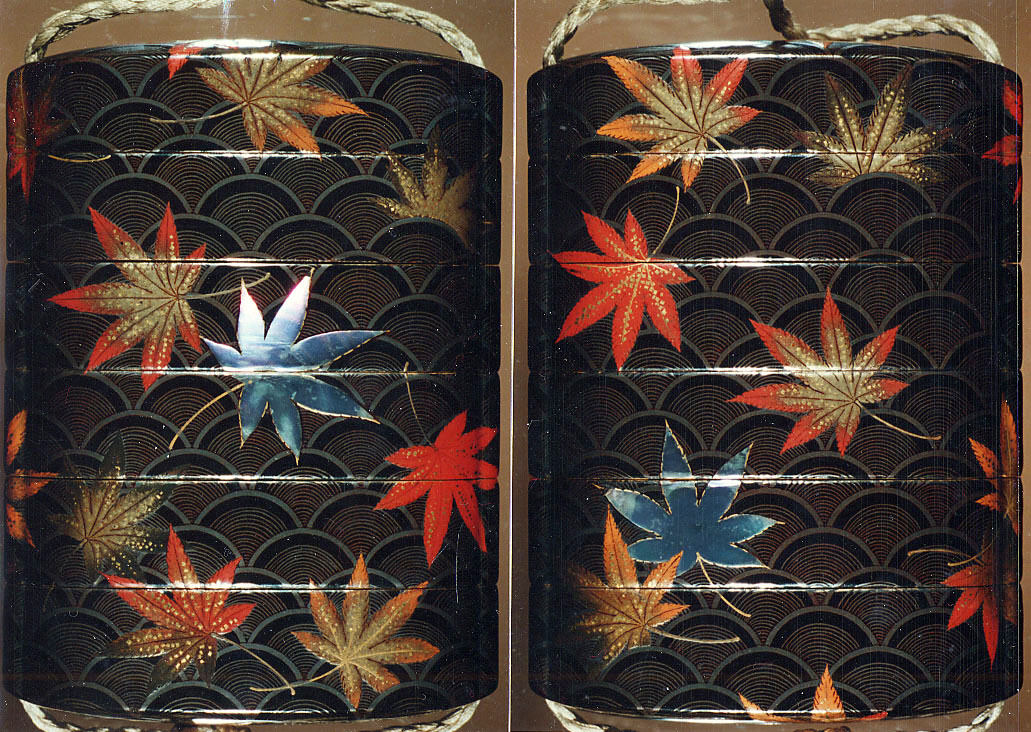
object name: inrō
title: Case (Inrō) with Design of Maple Leaves on Conventionalized Waves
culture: japanese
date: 1820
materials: gold, ivory, lacquer, mother of pearl, silver, wood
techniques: carving, fundame, inlay, roiro